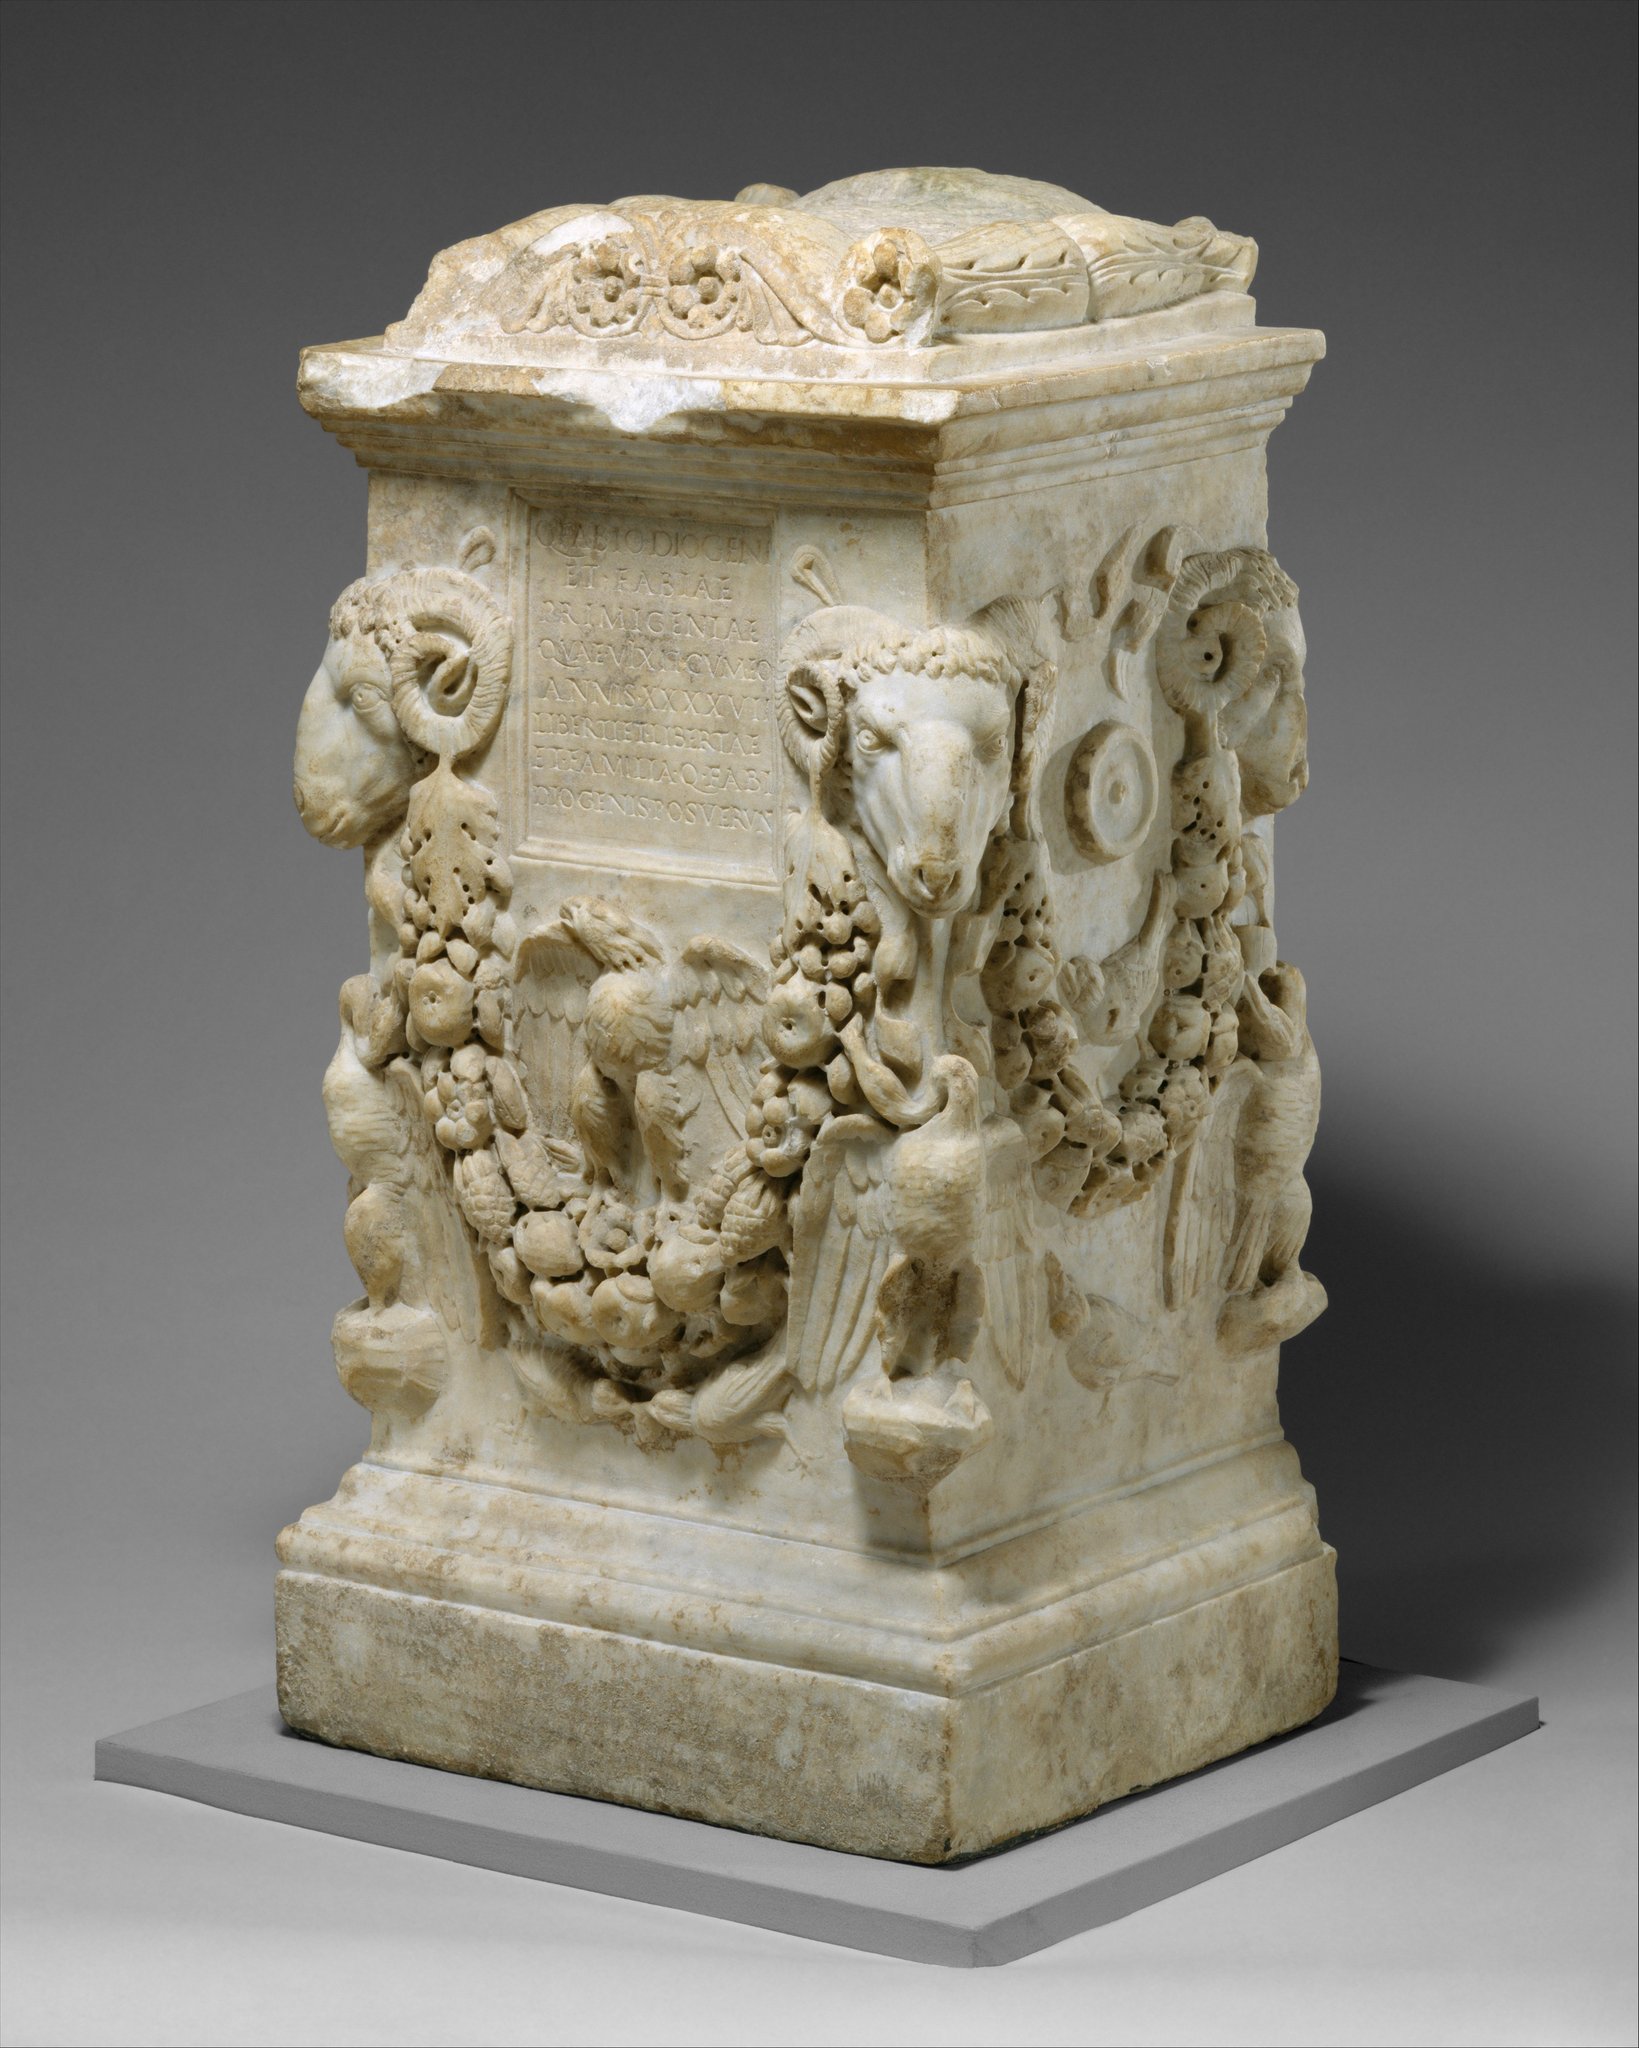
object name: cippus of quintus fabius diogenes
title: Marble funerary altar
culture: roman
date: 14-68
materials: marble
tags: eagles,altars,garlands,rams